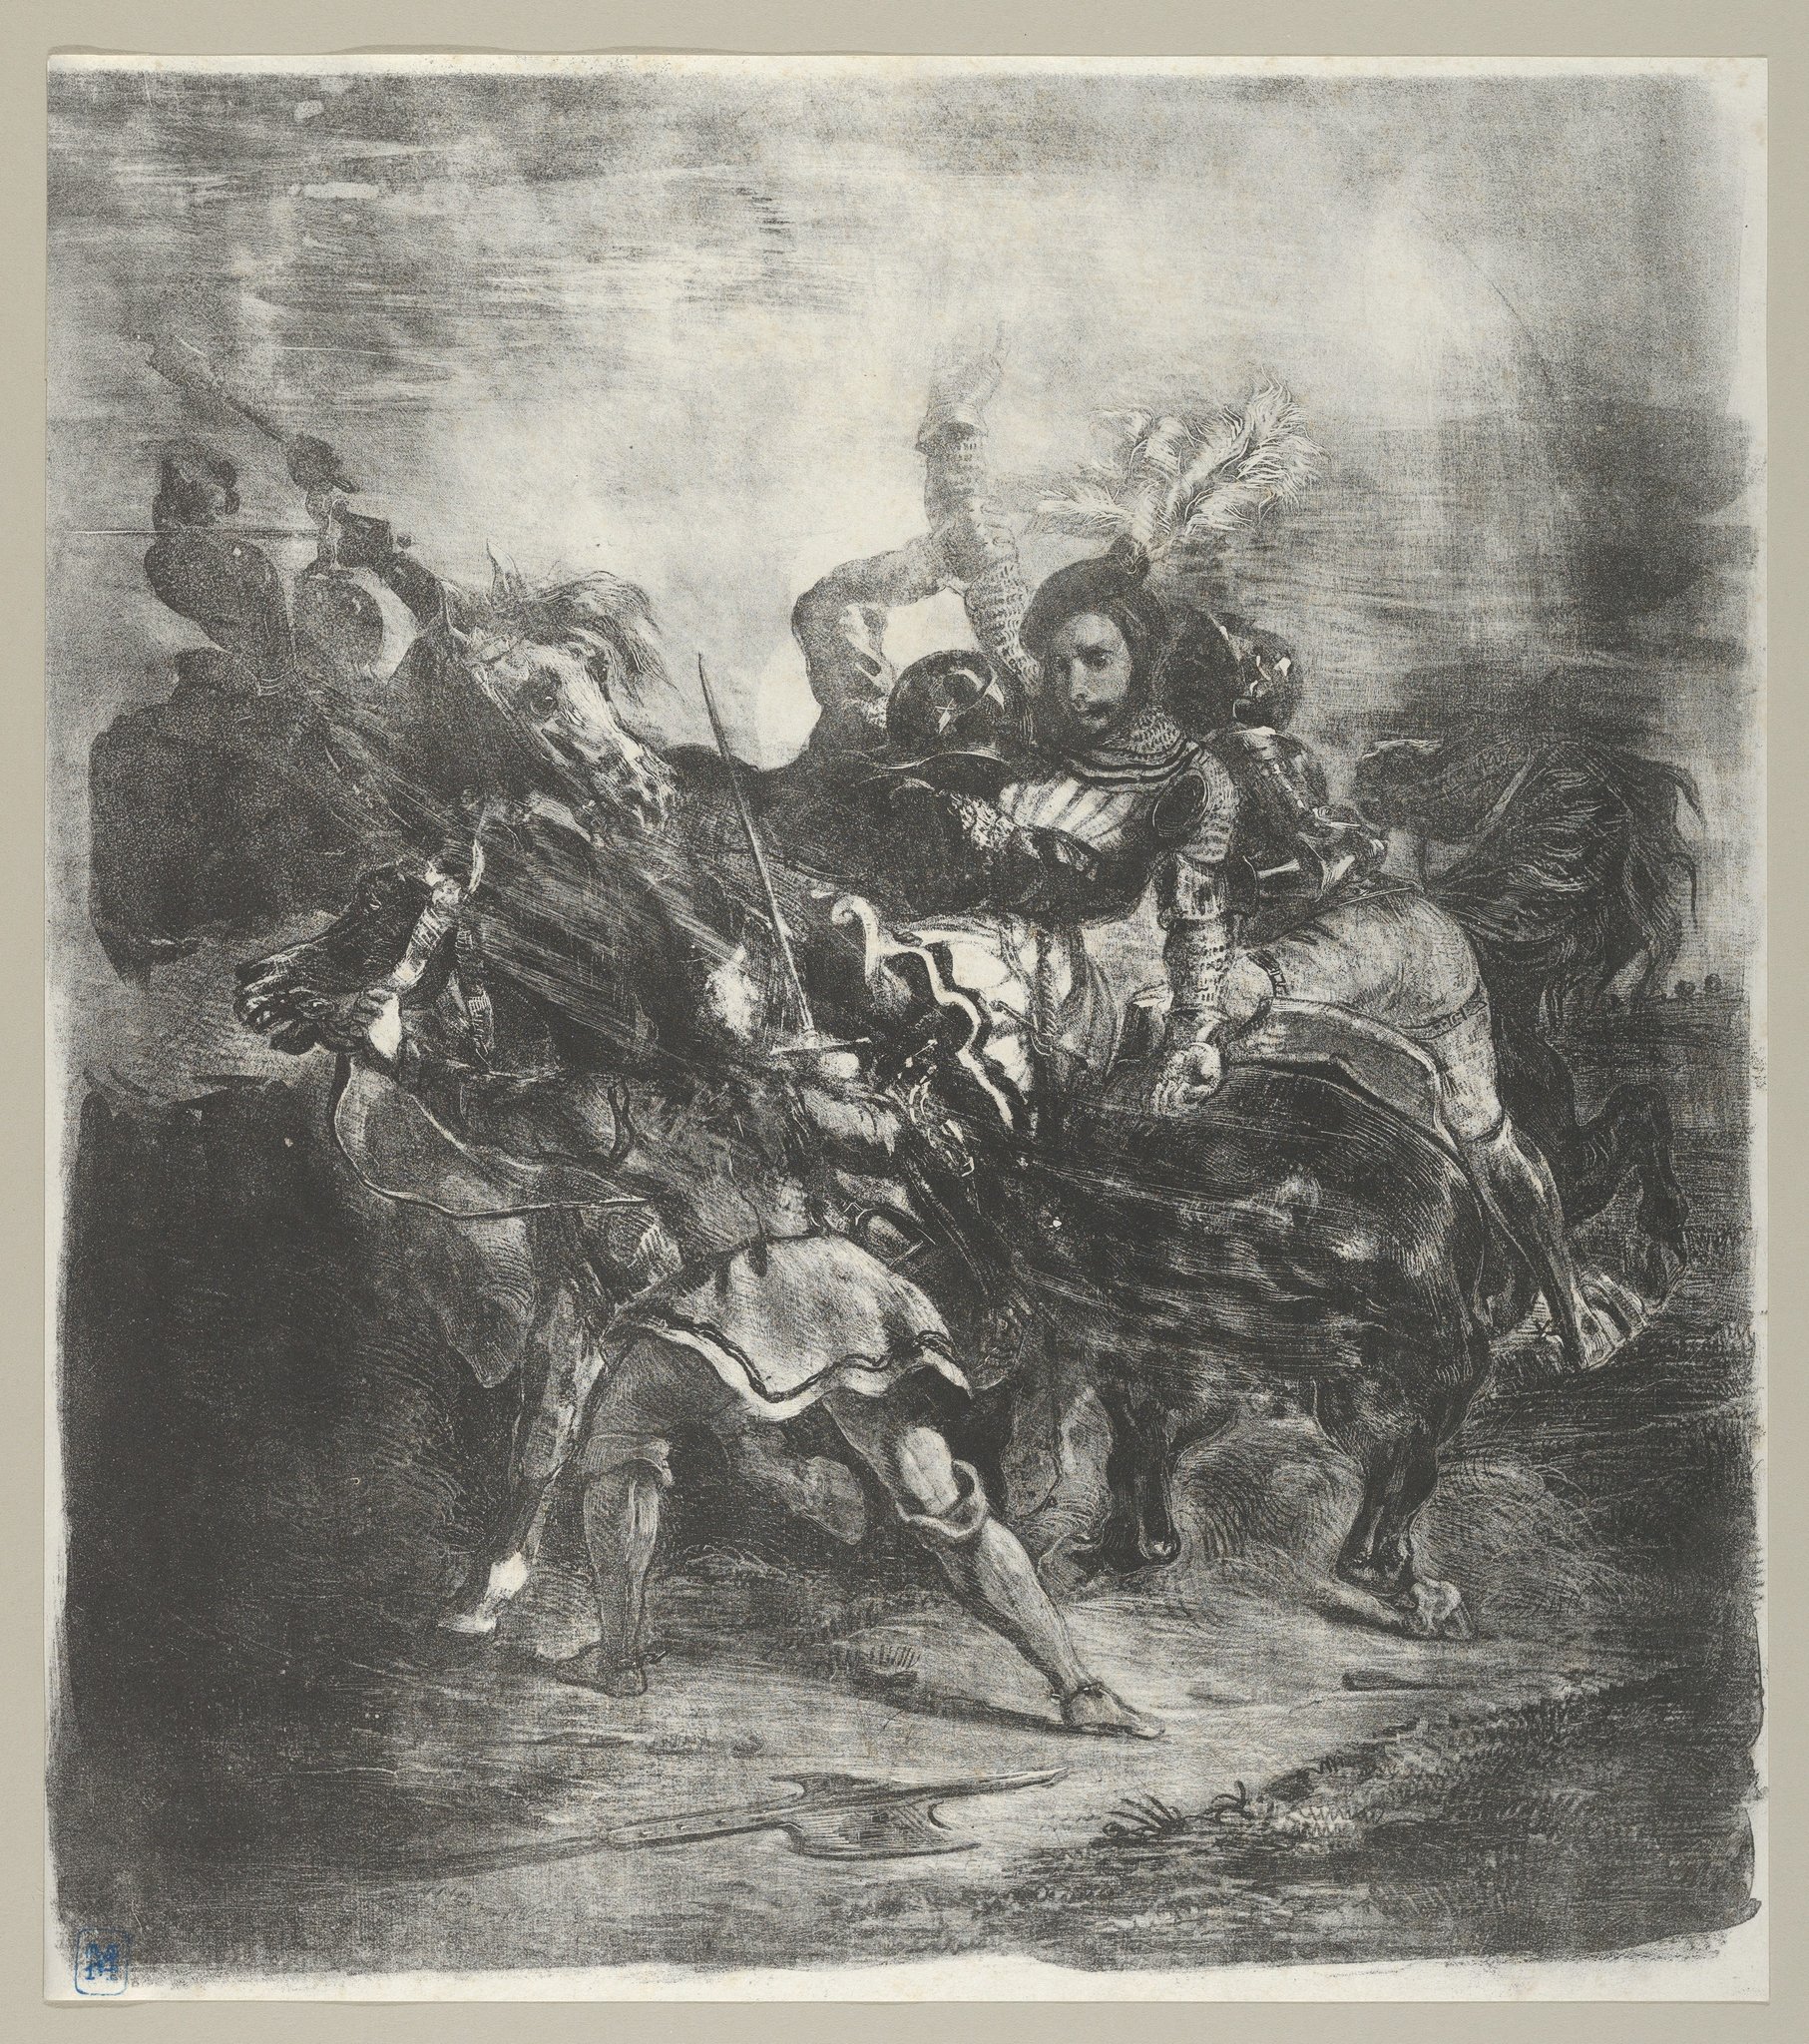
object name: print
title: Weislingen attacked by Goetz's Men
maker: eugène delacroix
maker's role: artist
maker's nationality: french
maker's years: 1798-1863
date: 1836-1843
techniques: lithograph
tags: wars,weapons,men,horses